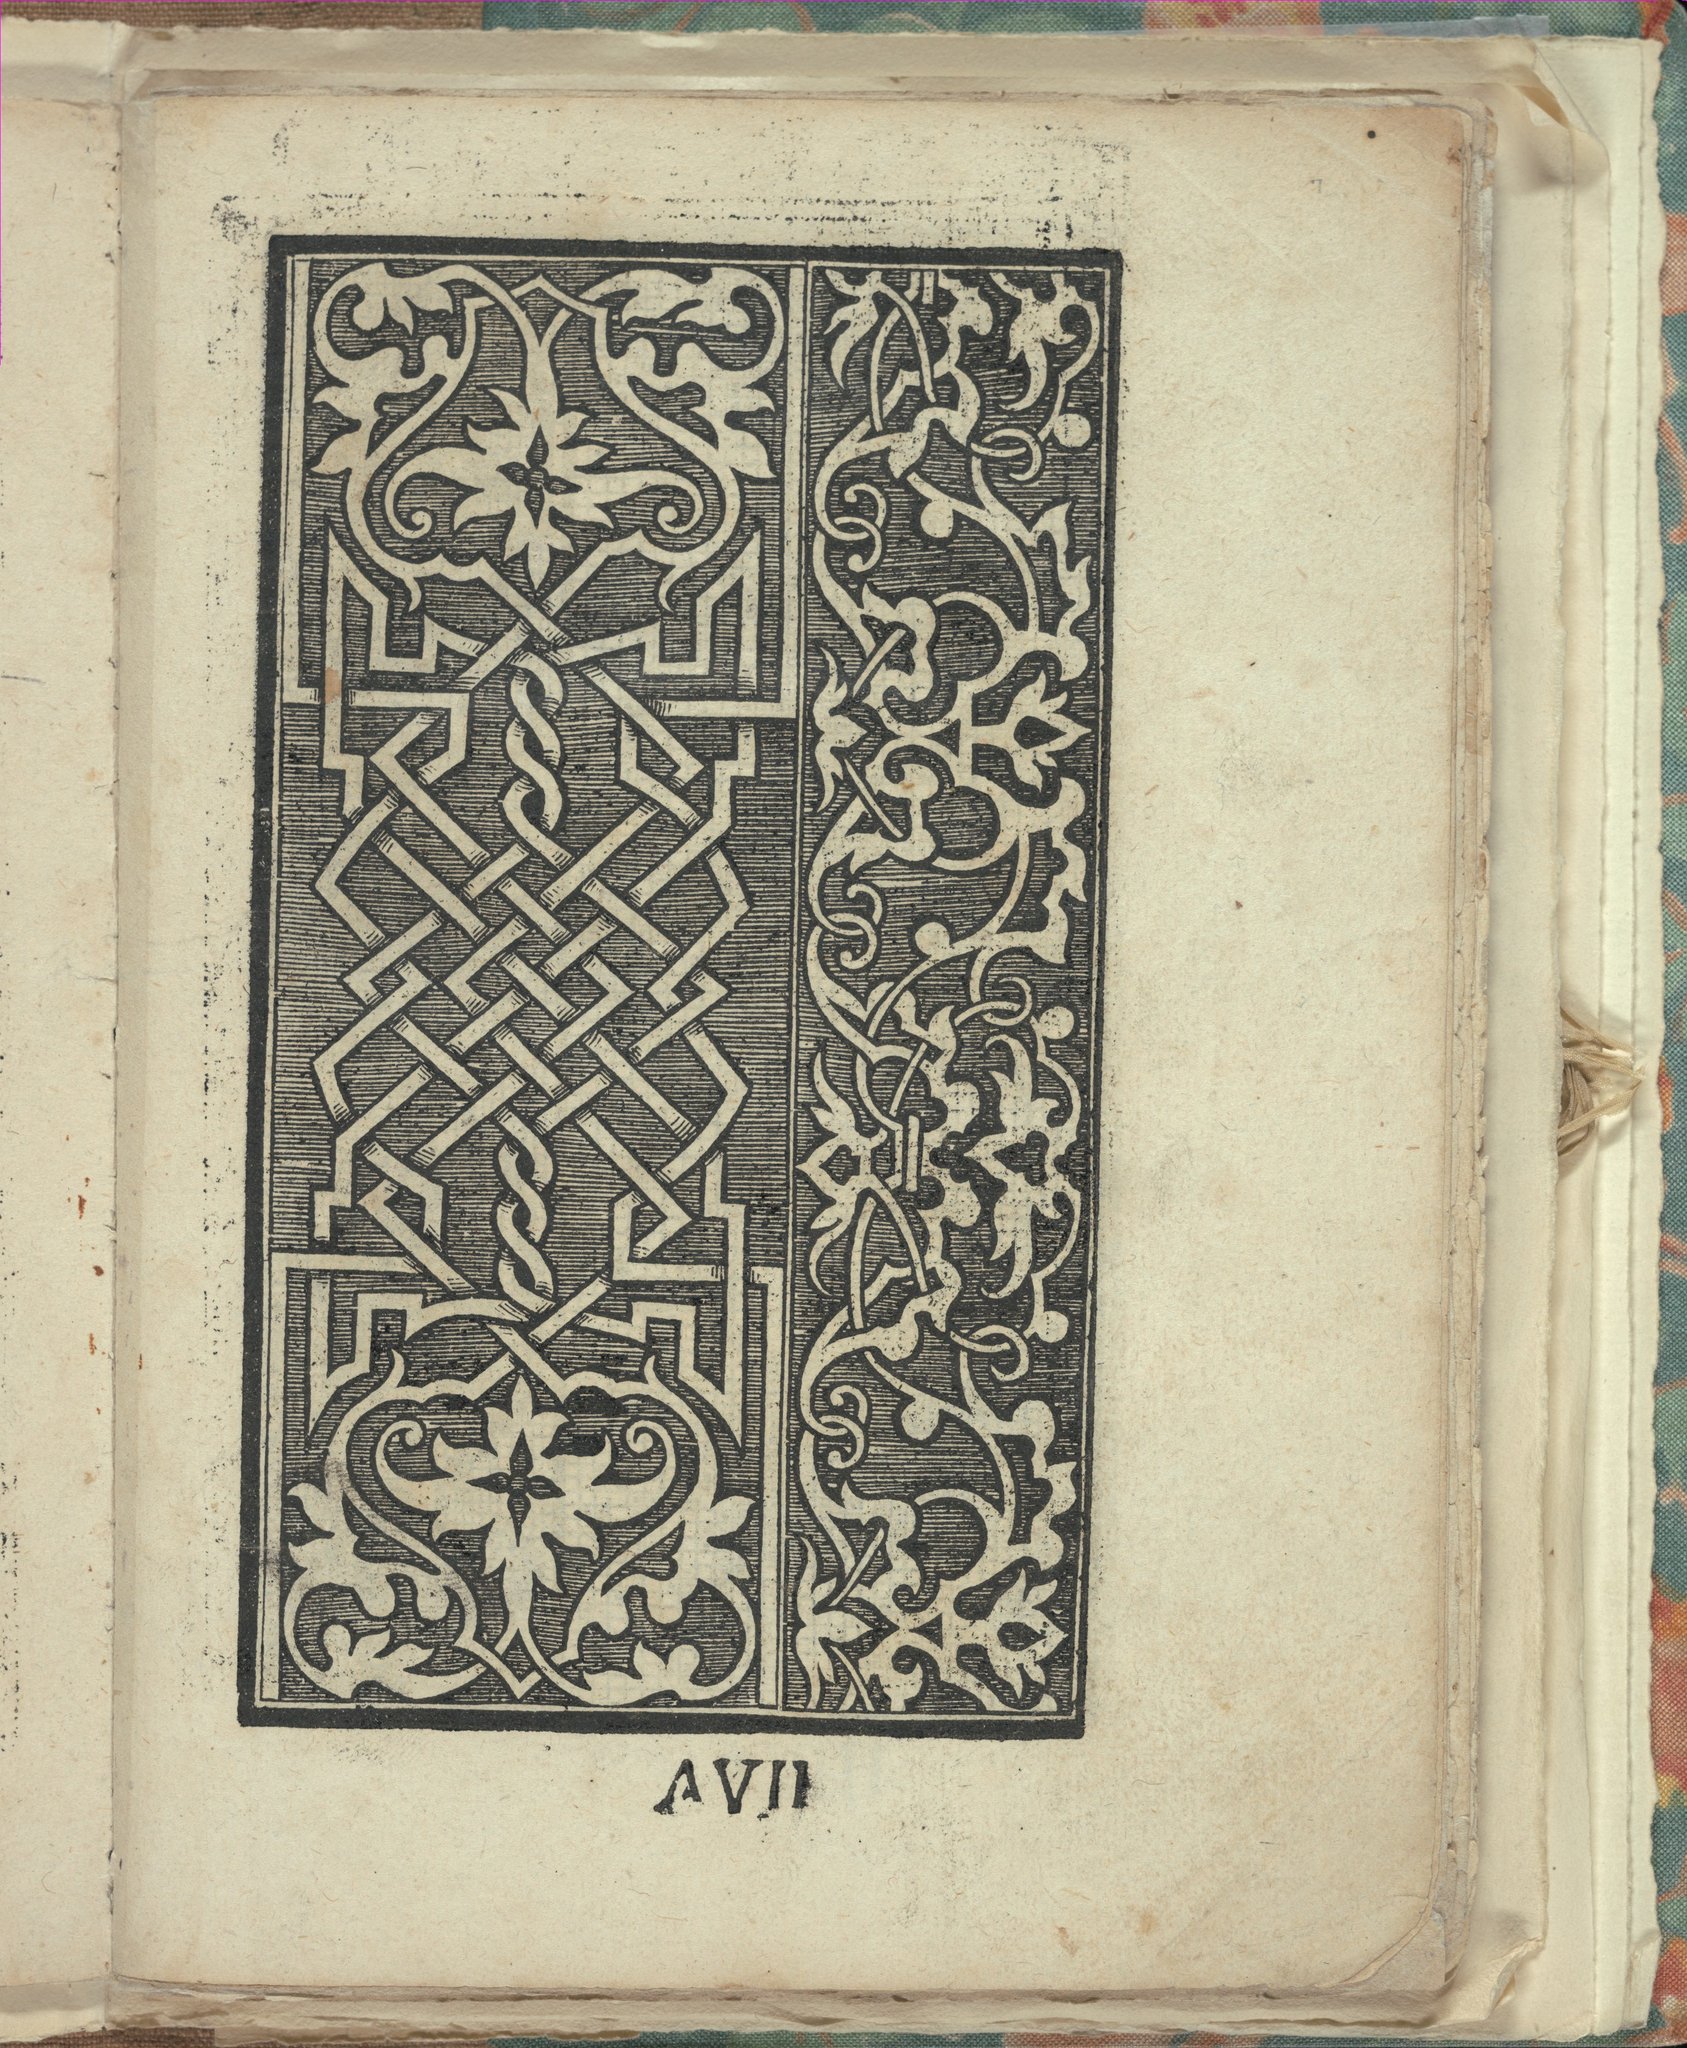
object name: book print ornament architecture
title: Opera Nova Universali intitulata Corona di racammi, page 7 (recto)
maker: giovanni andrea vavassore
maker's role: publisher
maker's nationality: italian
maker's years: 1530-1573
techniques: woodcut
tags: flowers,leaves